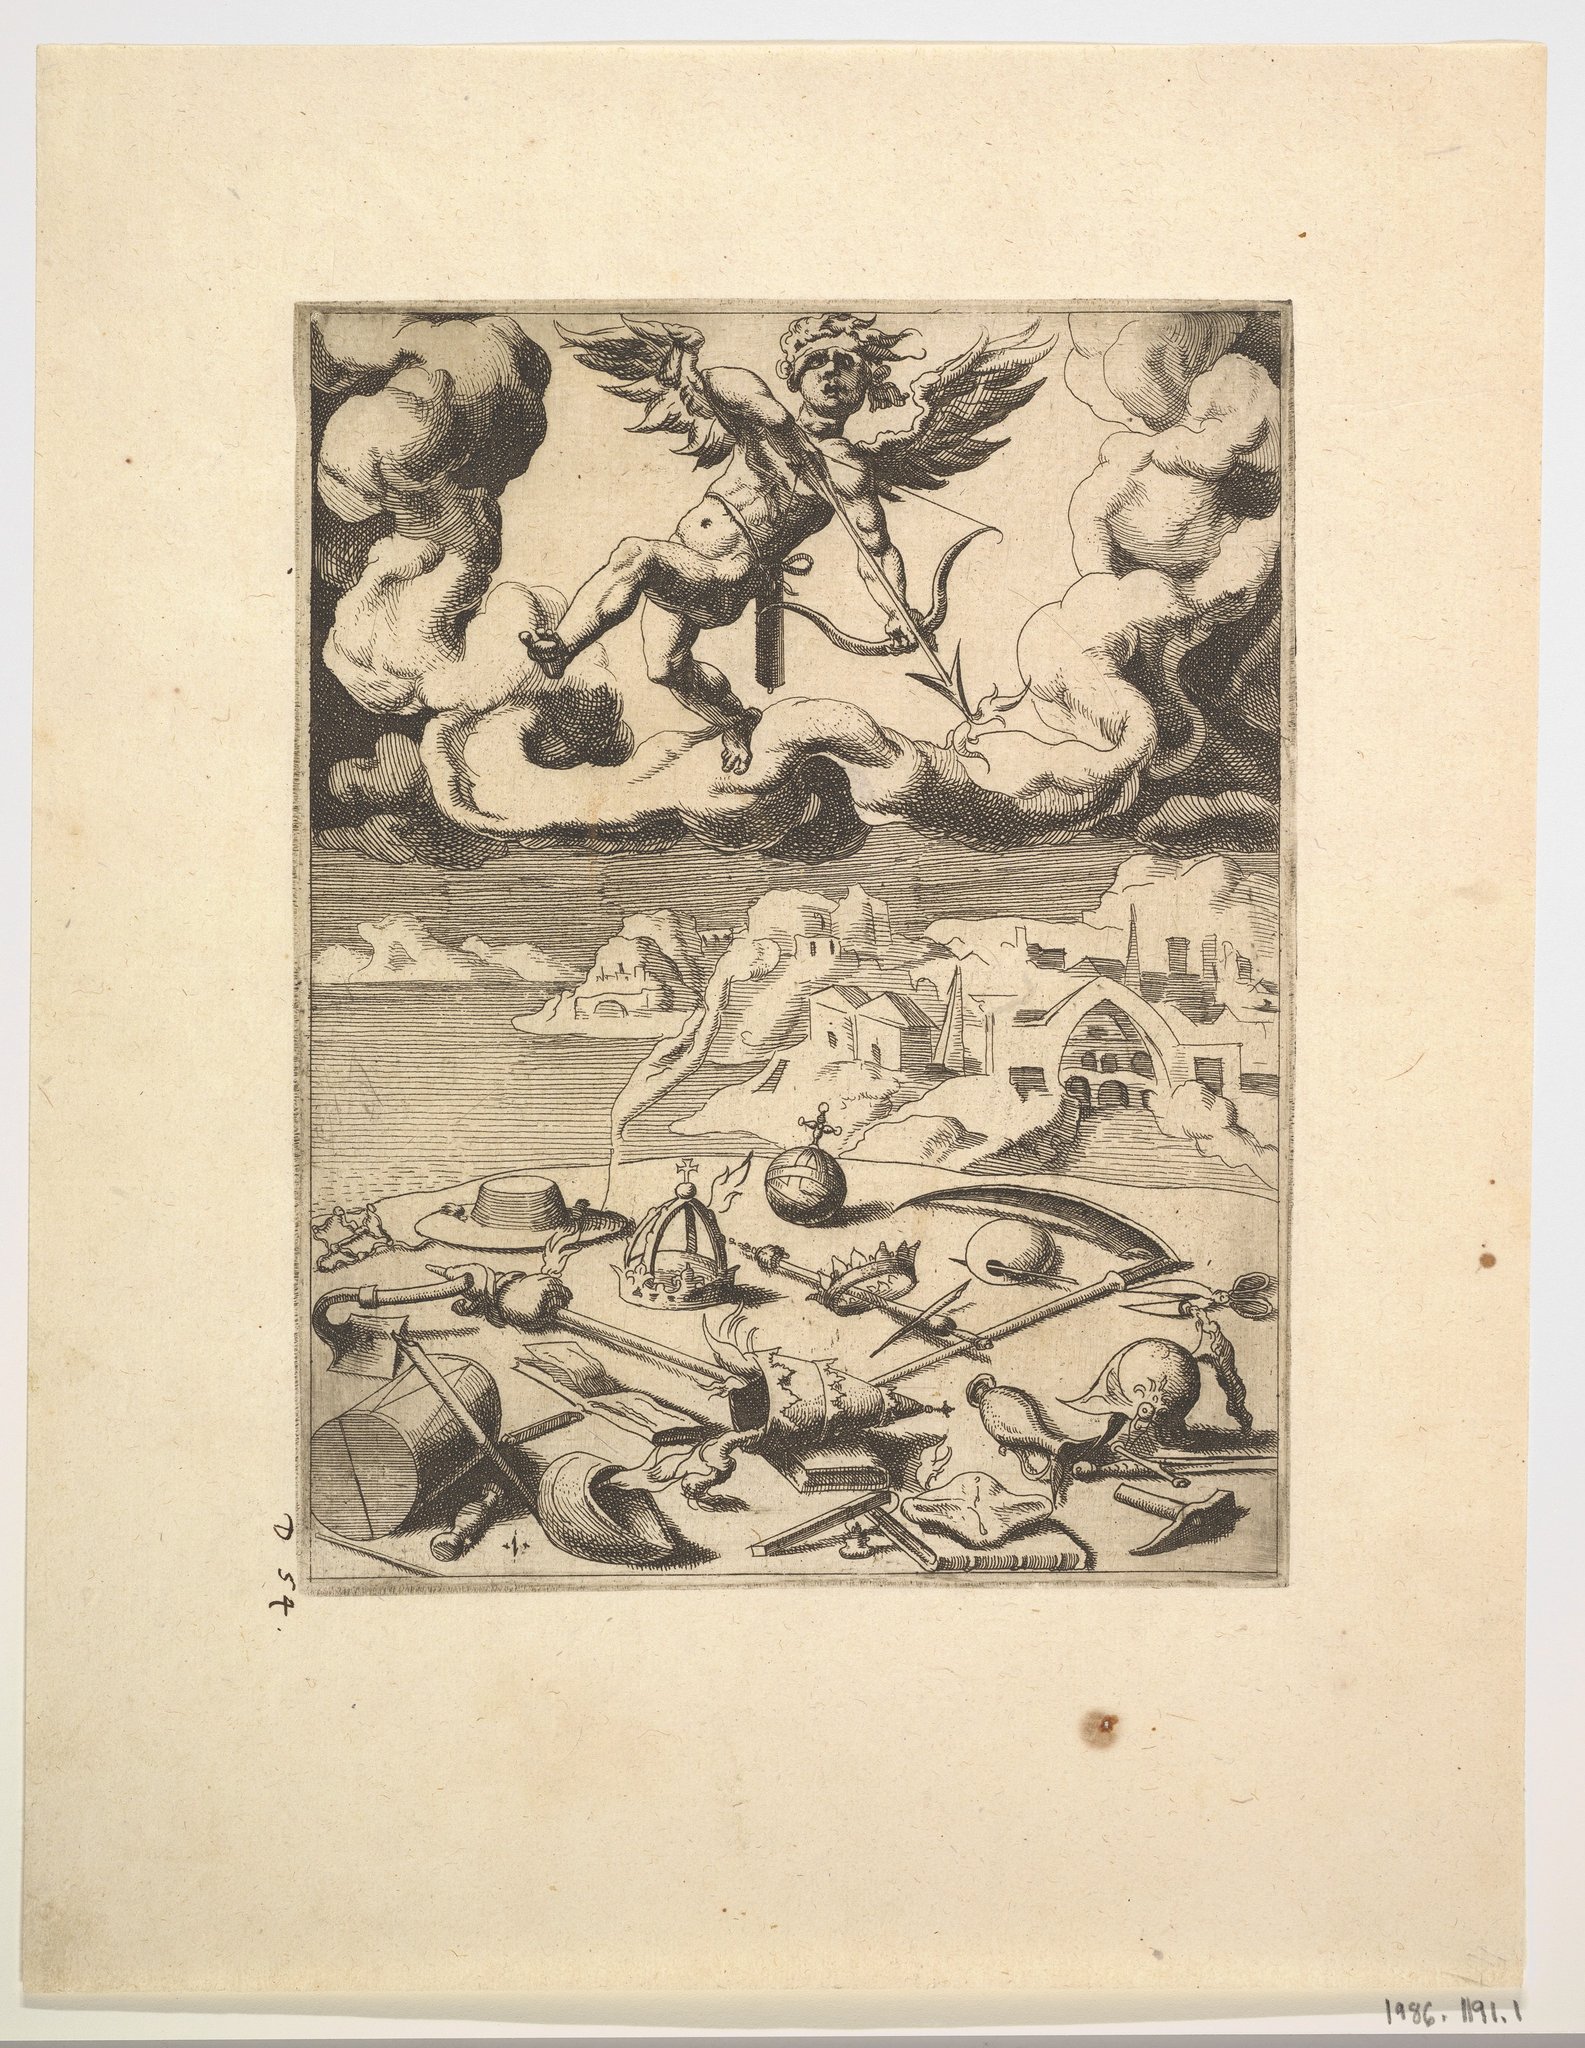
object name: print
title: The Triumph of Love from The Triumphs of Petrarch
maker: dirck volckertsz coornhert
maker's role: artist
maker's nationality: netherlandish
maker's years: 1519-1590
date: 1548-1549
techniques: etching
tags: hats,bow and arrow,helmets,cupid,crowns